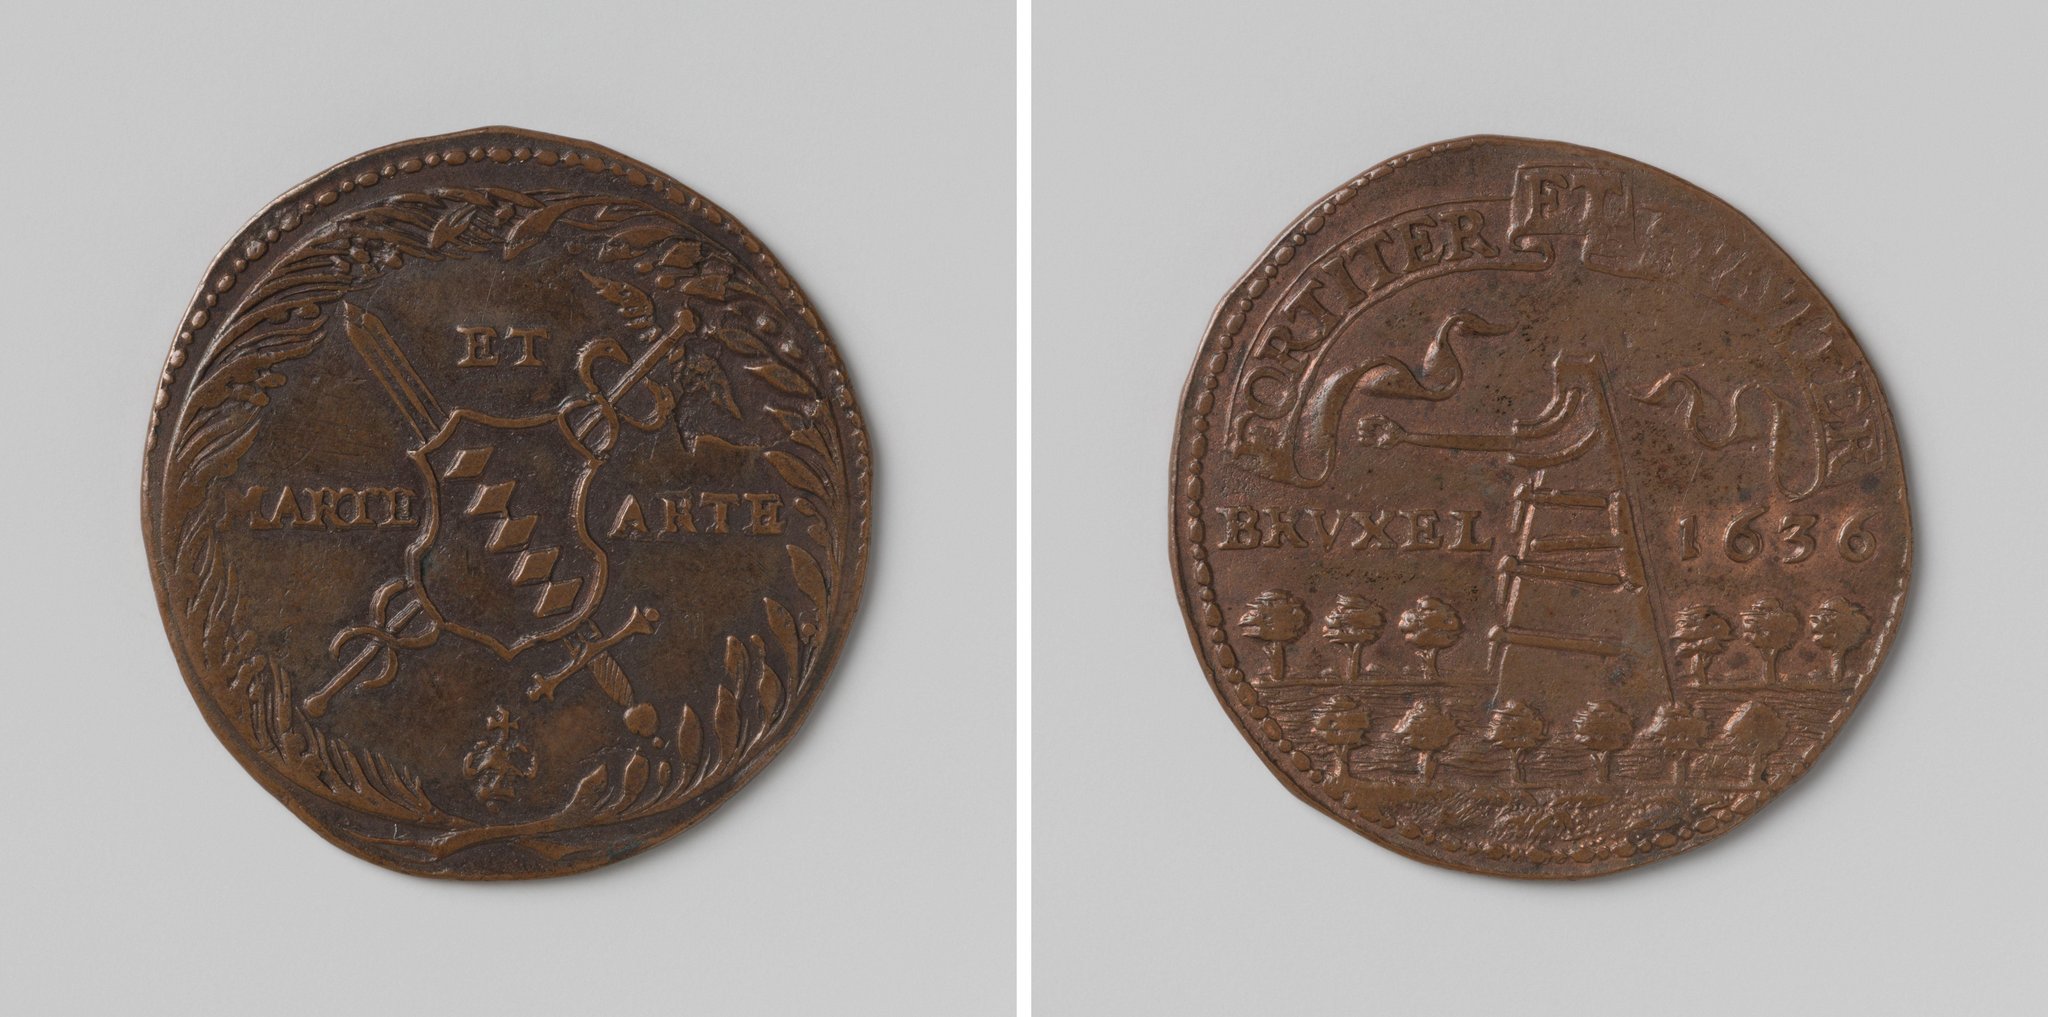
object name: jeton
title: Frederik de Marselaer, zevenentwintigste intendant van de vaart van Brussel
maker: balthasar laureys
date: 1636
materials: copper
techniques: striking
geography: brussels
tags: staatsman, frederik de marselaer, willebroekse vaart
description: Koperen penning. Voorzijde: wapenschild op gekruist zwaard en Mercuriusstaf tussen opschrift binnen tot krans samengebonden lauwer- en palmtak. Keerzijde: arm met gebalde vuist, stekend uit windas, staande aan zijde van kanaal tussen opschrift onder wimpel met opschrift